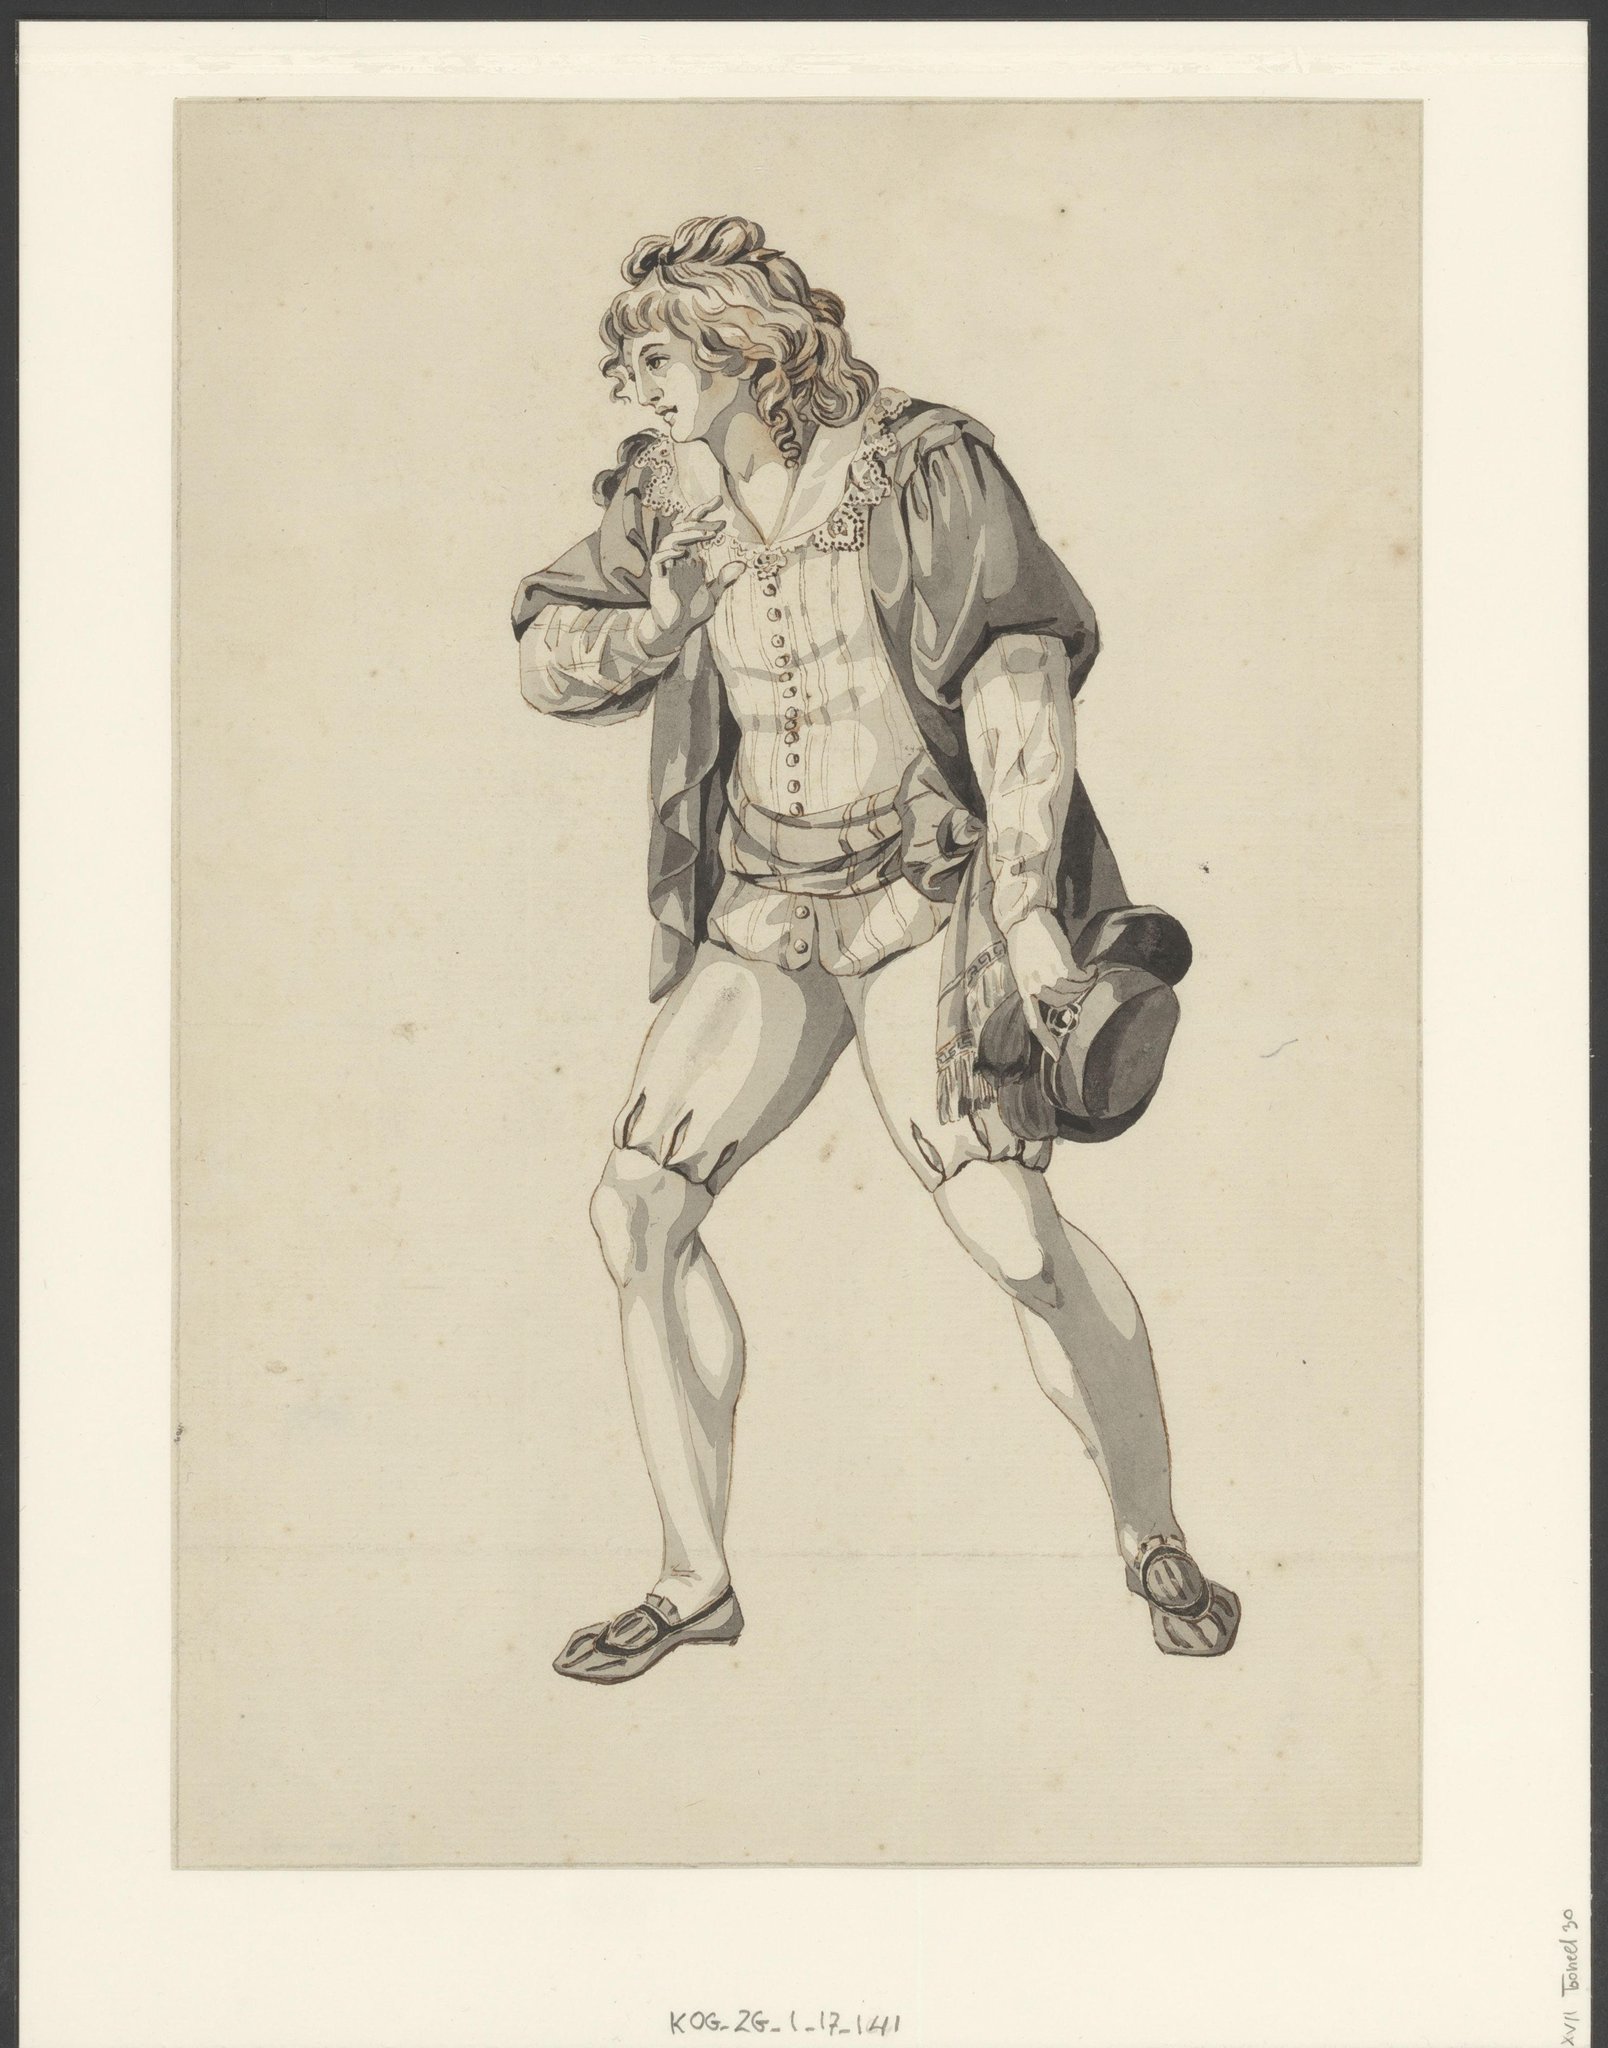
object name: drawing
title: Acteur in kostuum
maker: Anonymous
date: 1750-1849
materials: ink, paper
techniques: brush, pen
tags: stage costume, actor (on the stage)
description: Onderwerpsrubrieken binnen de Atlas Zeden en Gewoonten: Tooneel, Portretten van toneelspelers.